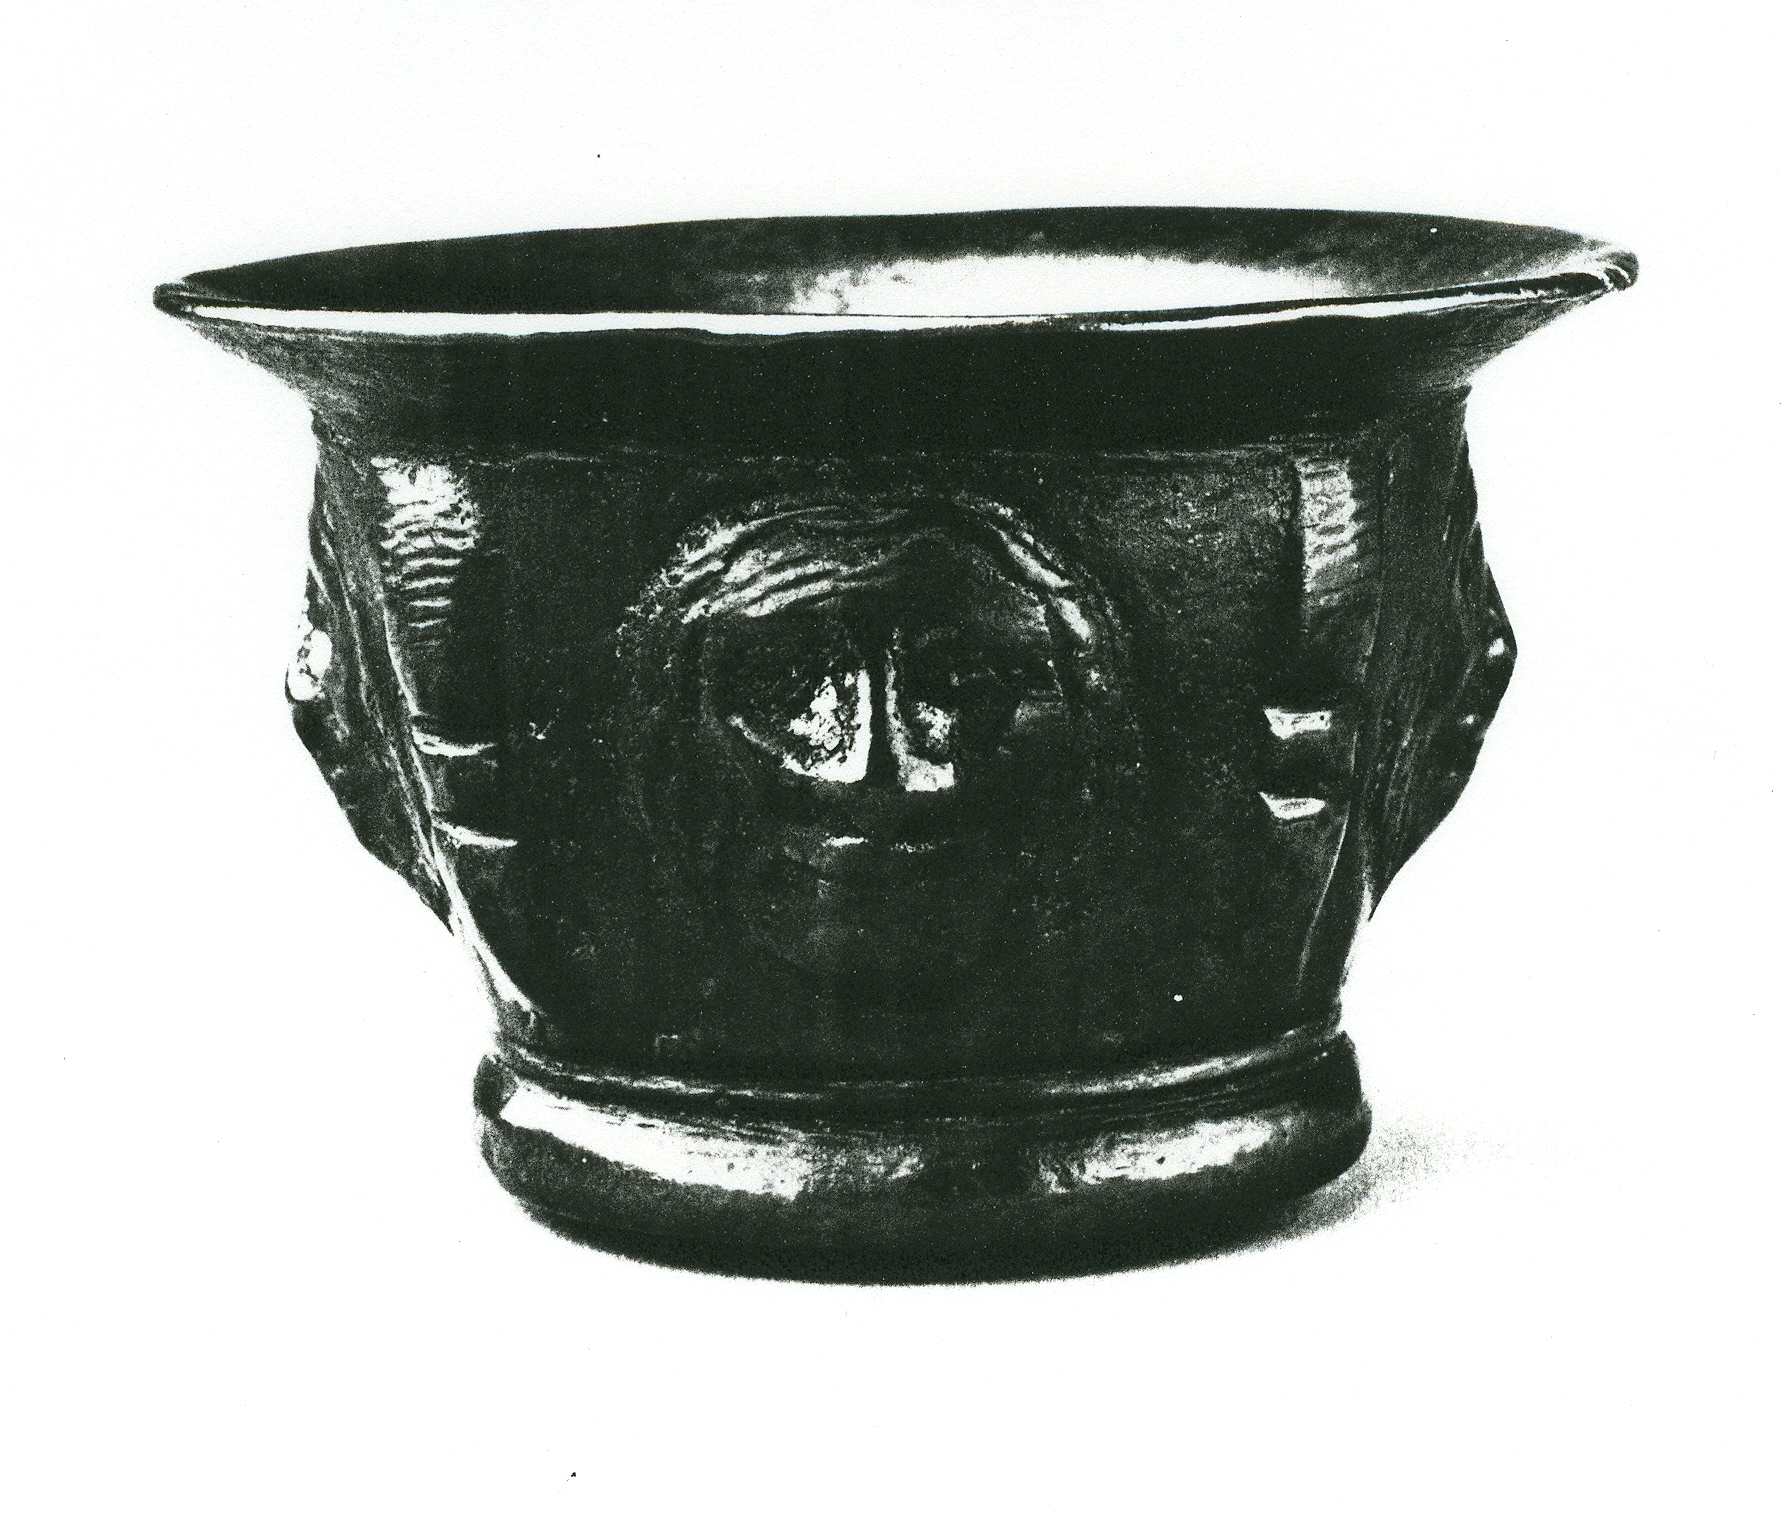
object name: mortar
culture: italian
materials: copper alloy, patina